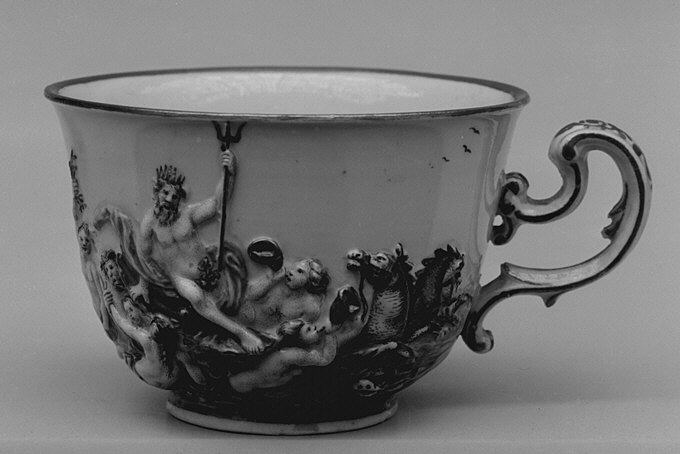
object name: teacup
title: Tea cup (part of a service)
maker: doccia porcelain manufactory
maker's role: manufactory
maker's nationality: italian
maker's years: 1737-1896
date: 1760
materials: hard paste porcelain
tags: male nudes,horses